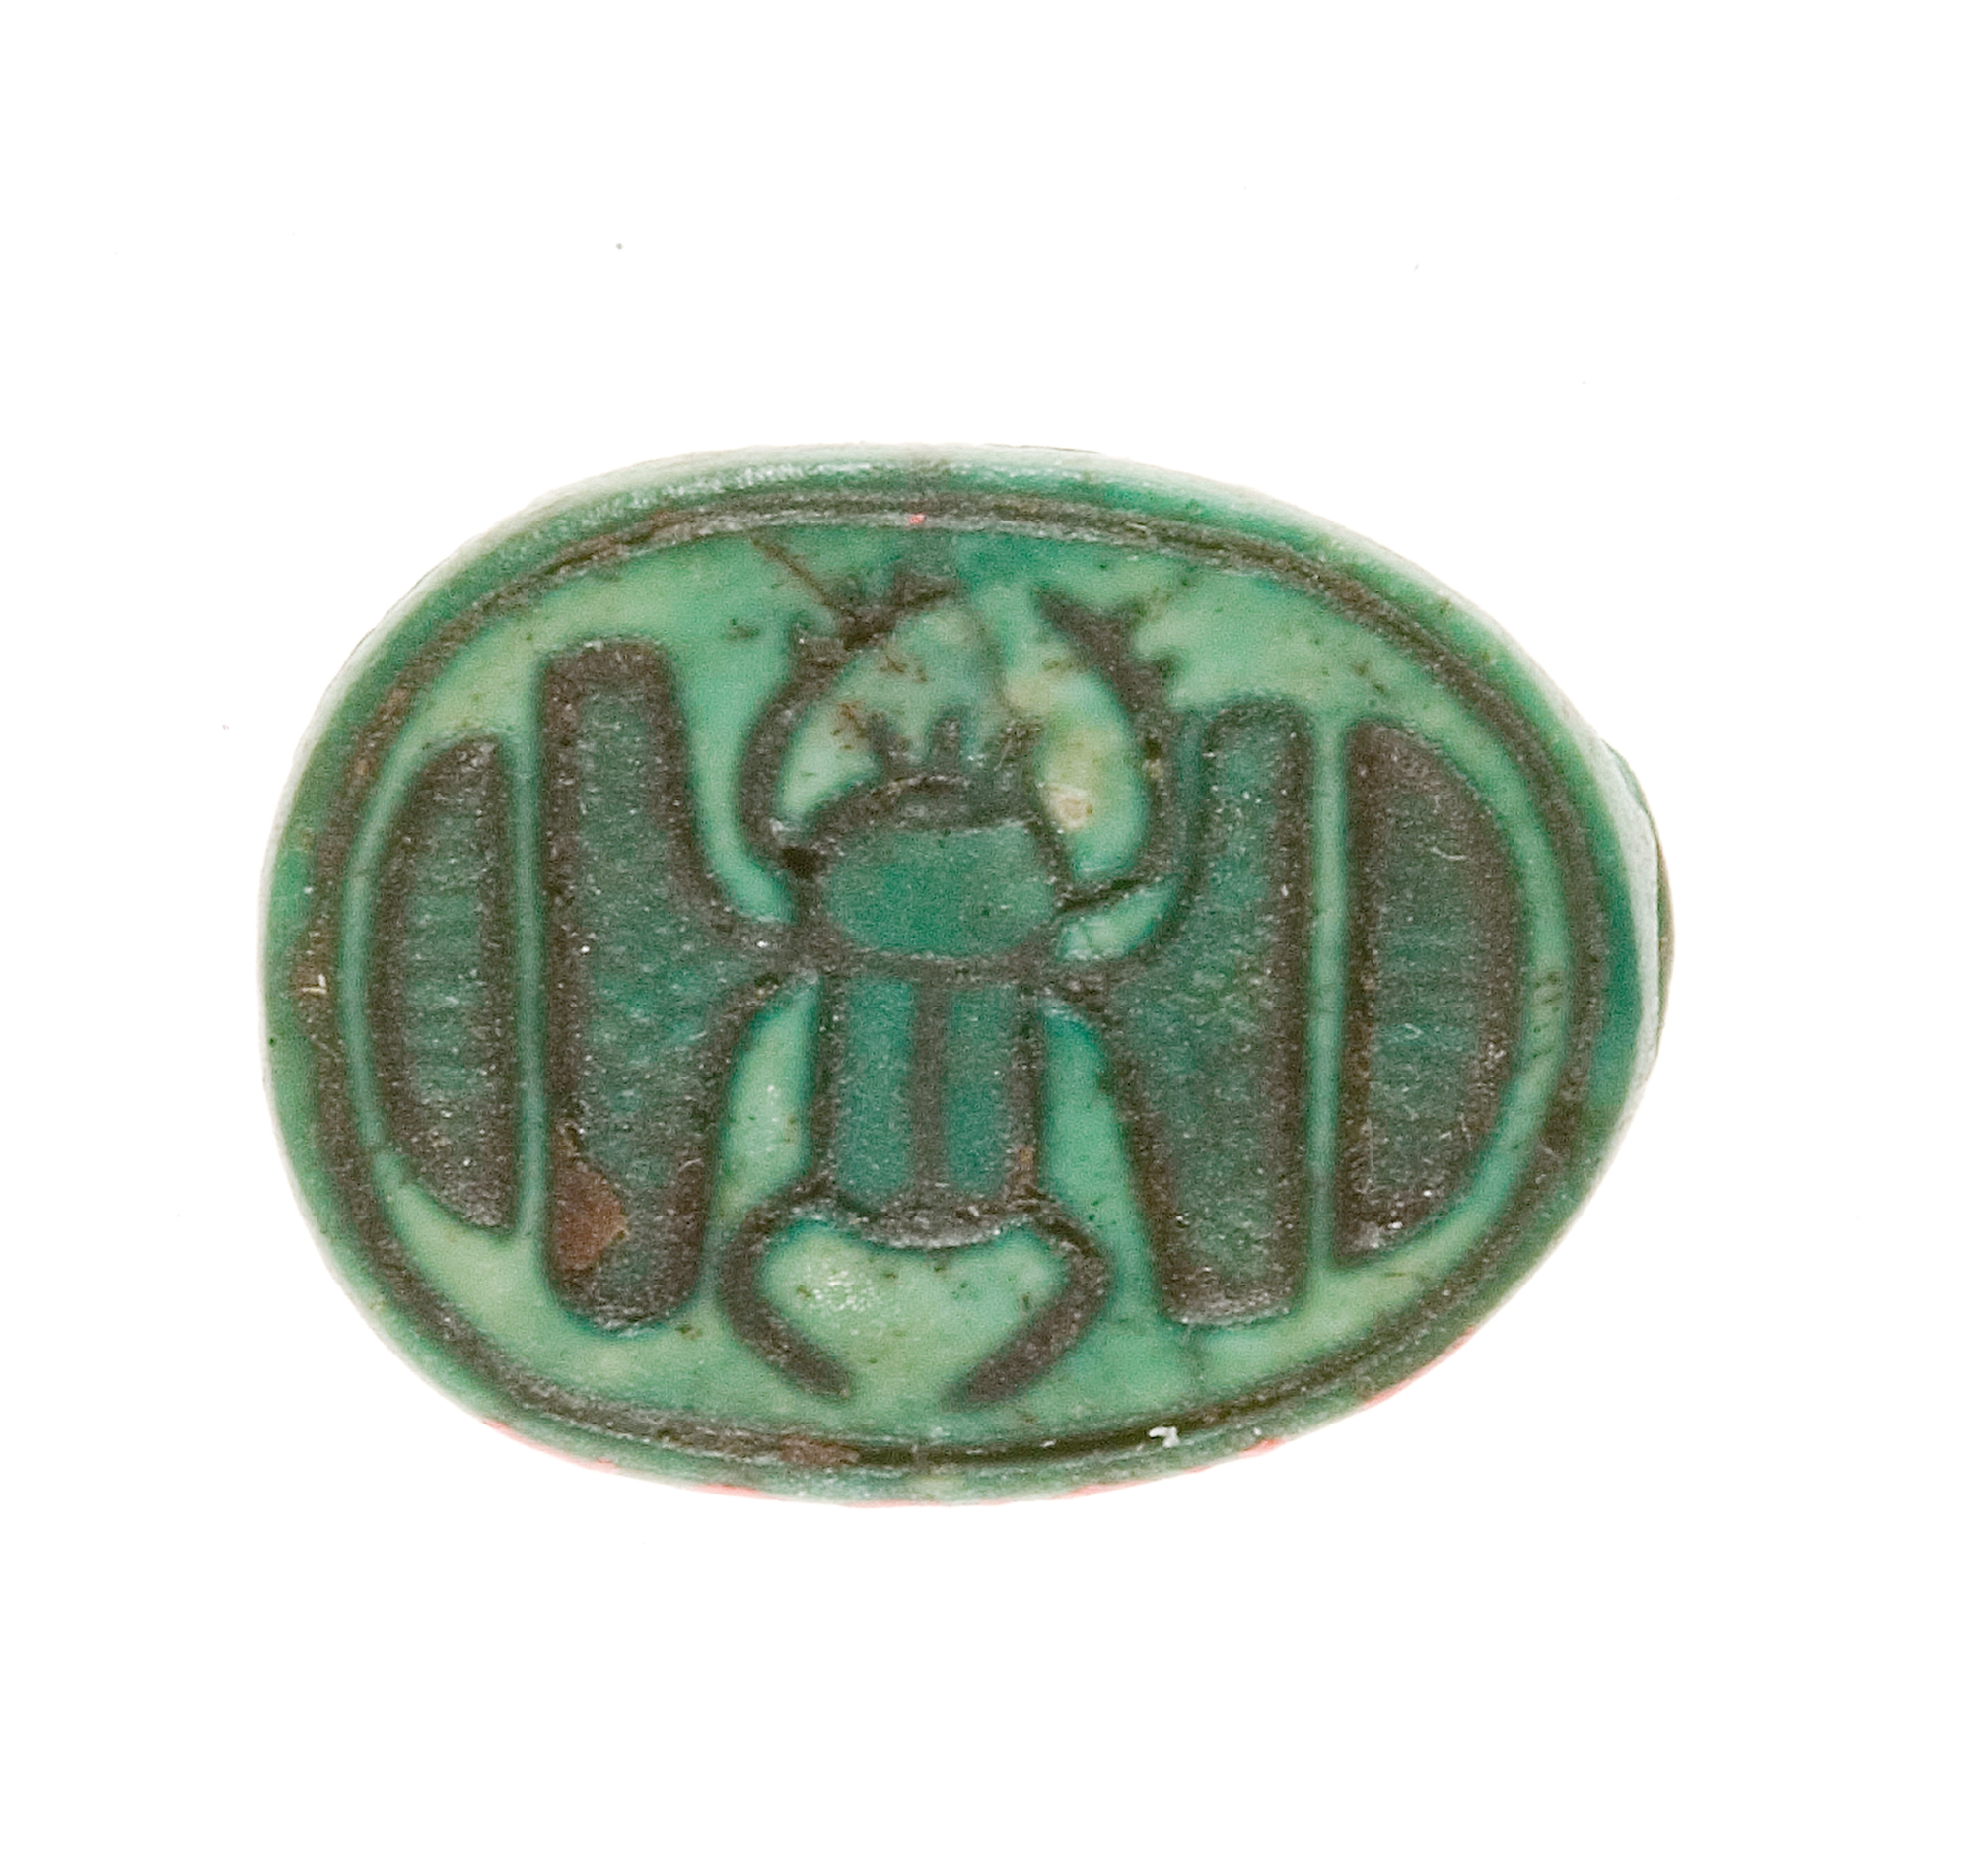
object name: scarab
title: Scarab Inscribed with a Hieroglyphic Motif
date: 1479-1458 BCE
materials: stone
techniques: glazing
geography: egypt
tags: hieroglyphs,scarabs